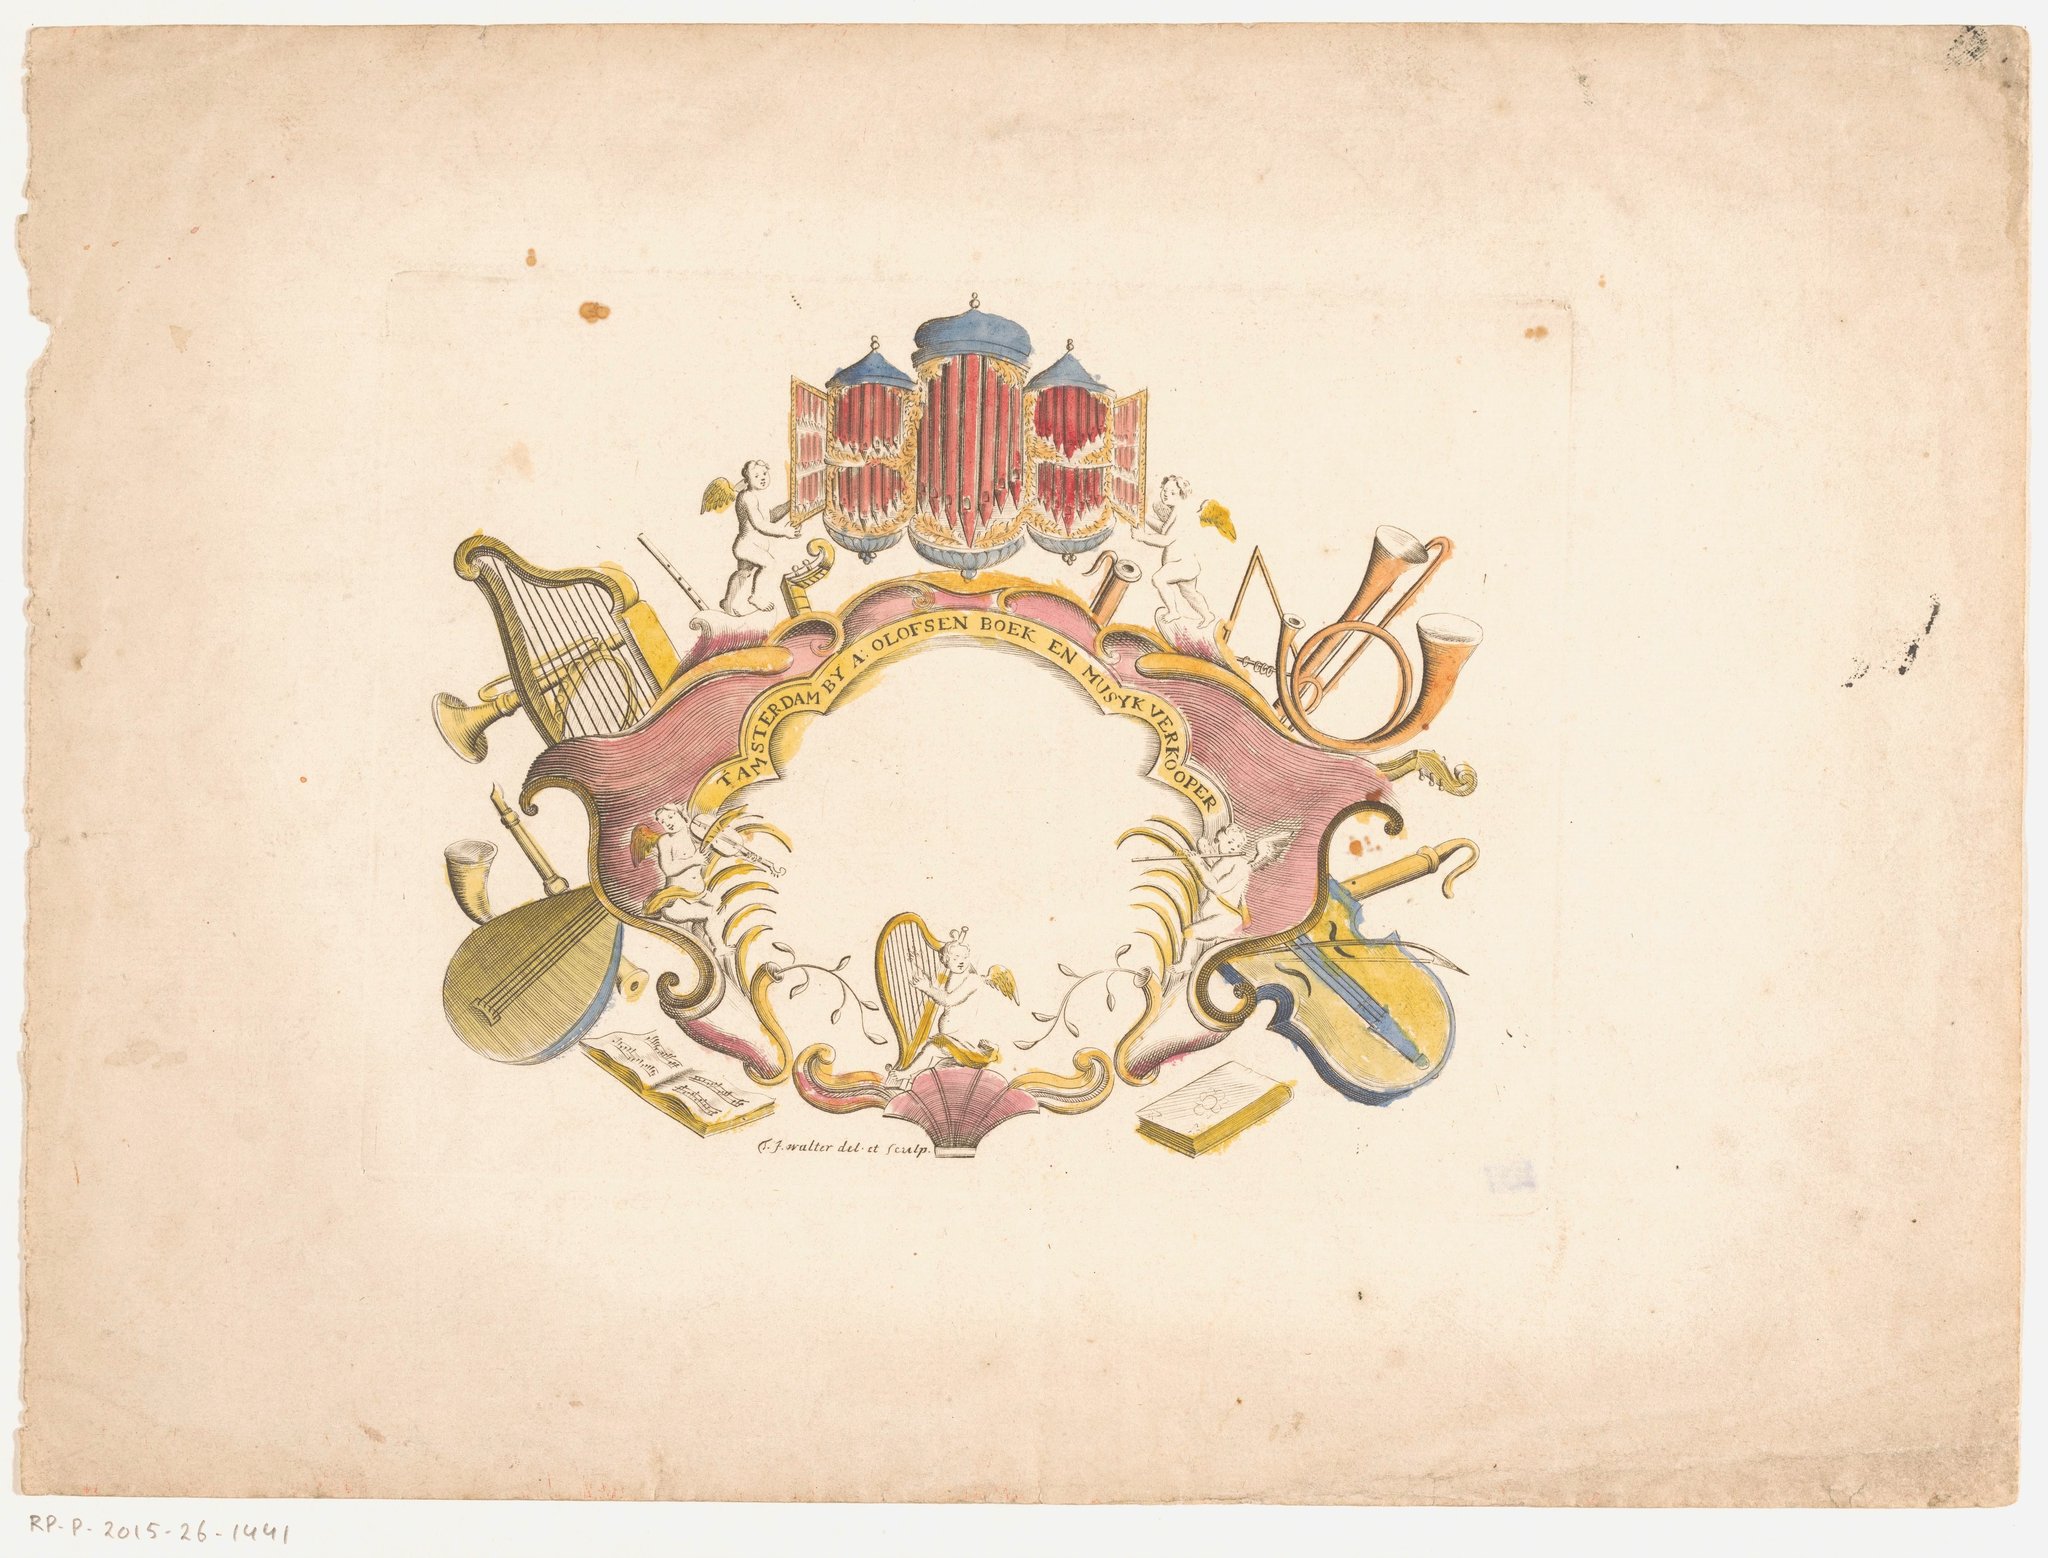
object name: handelsetiket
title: Cartouche gedecoreerd met muziekinstrumenten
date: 1738-1772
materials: paper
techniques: engraving, hand coloring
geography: harderwijk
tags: wind instruments, string instruments (plucked), string instruments (bowed)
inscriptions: collector's mark: Lugt 2228, collector's mark: Lugt 4780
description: Een leeg cartouche gedecoreerd met diverse blaas- en snaarinstrumenten, bekroond met een orgel. Onderaan een engel met een harp. Mogelijk een handelsetiket.